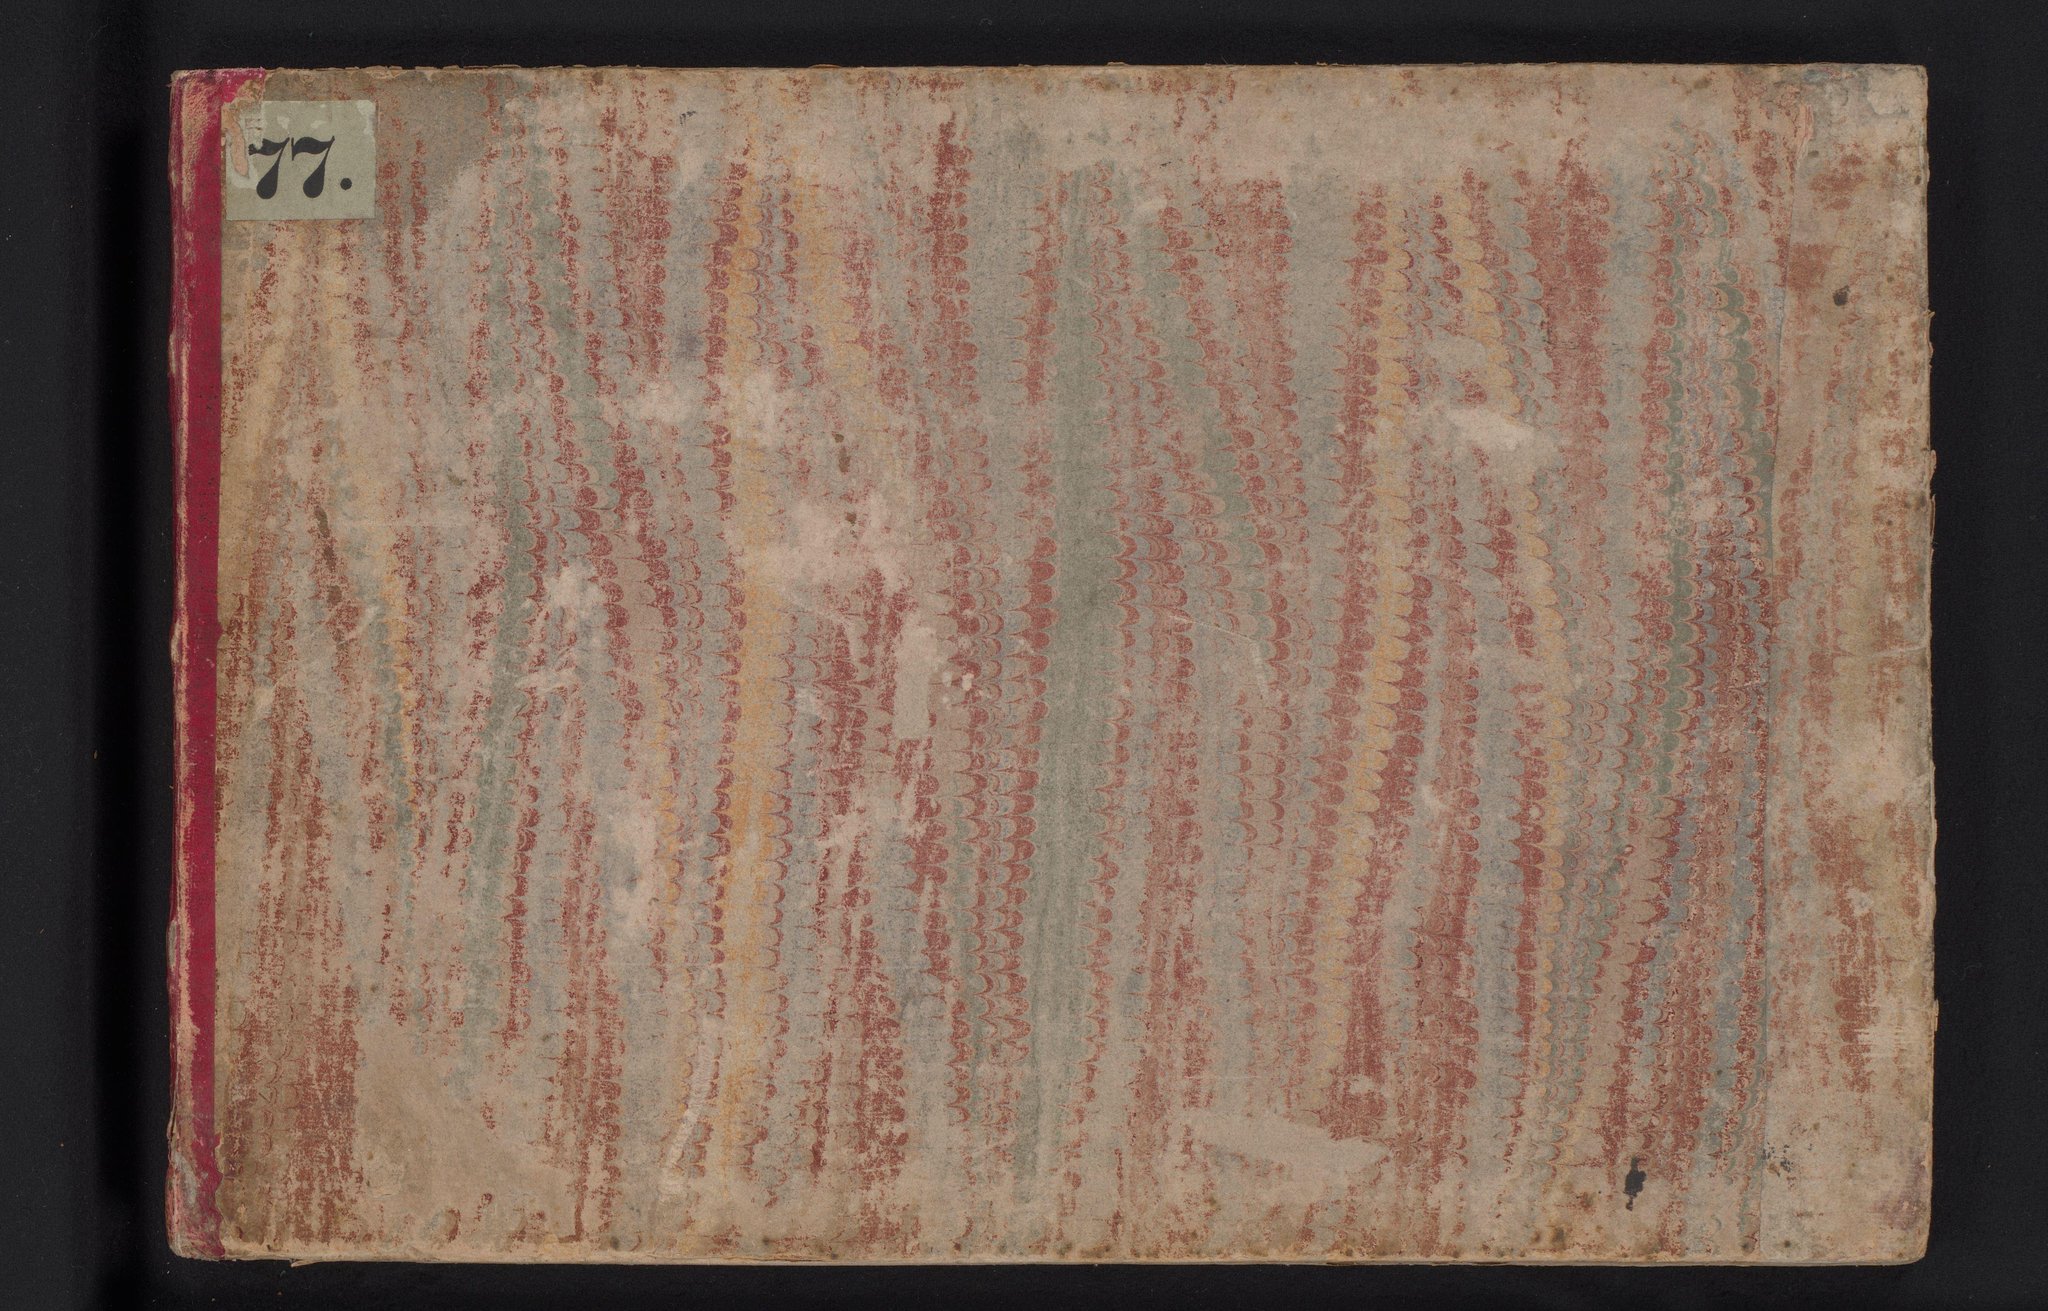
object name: prentrecueil, prentenalbum, prentalbum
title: Album met scènes uit het leven van paus Leo X en voorstellingen door Rafaël in het Vaticaan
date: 1627-1691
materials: cardboard, leather, paper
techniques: bookbinding, engraving, etching, marbling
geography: vatican city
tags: leo x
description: Album met 30 prenten op 30 bladen. Het album bevat prenten uit twee series: scènes uit het leven van paus Leo X en voorstellingen door Rafaël in het Vaticaan. Een kartonnen band, beplakt met rood leer en marmerpapier. Achterin zit een blanco schutblad.